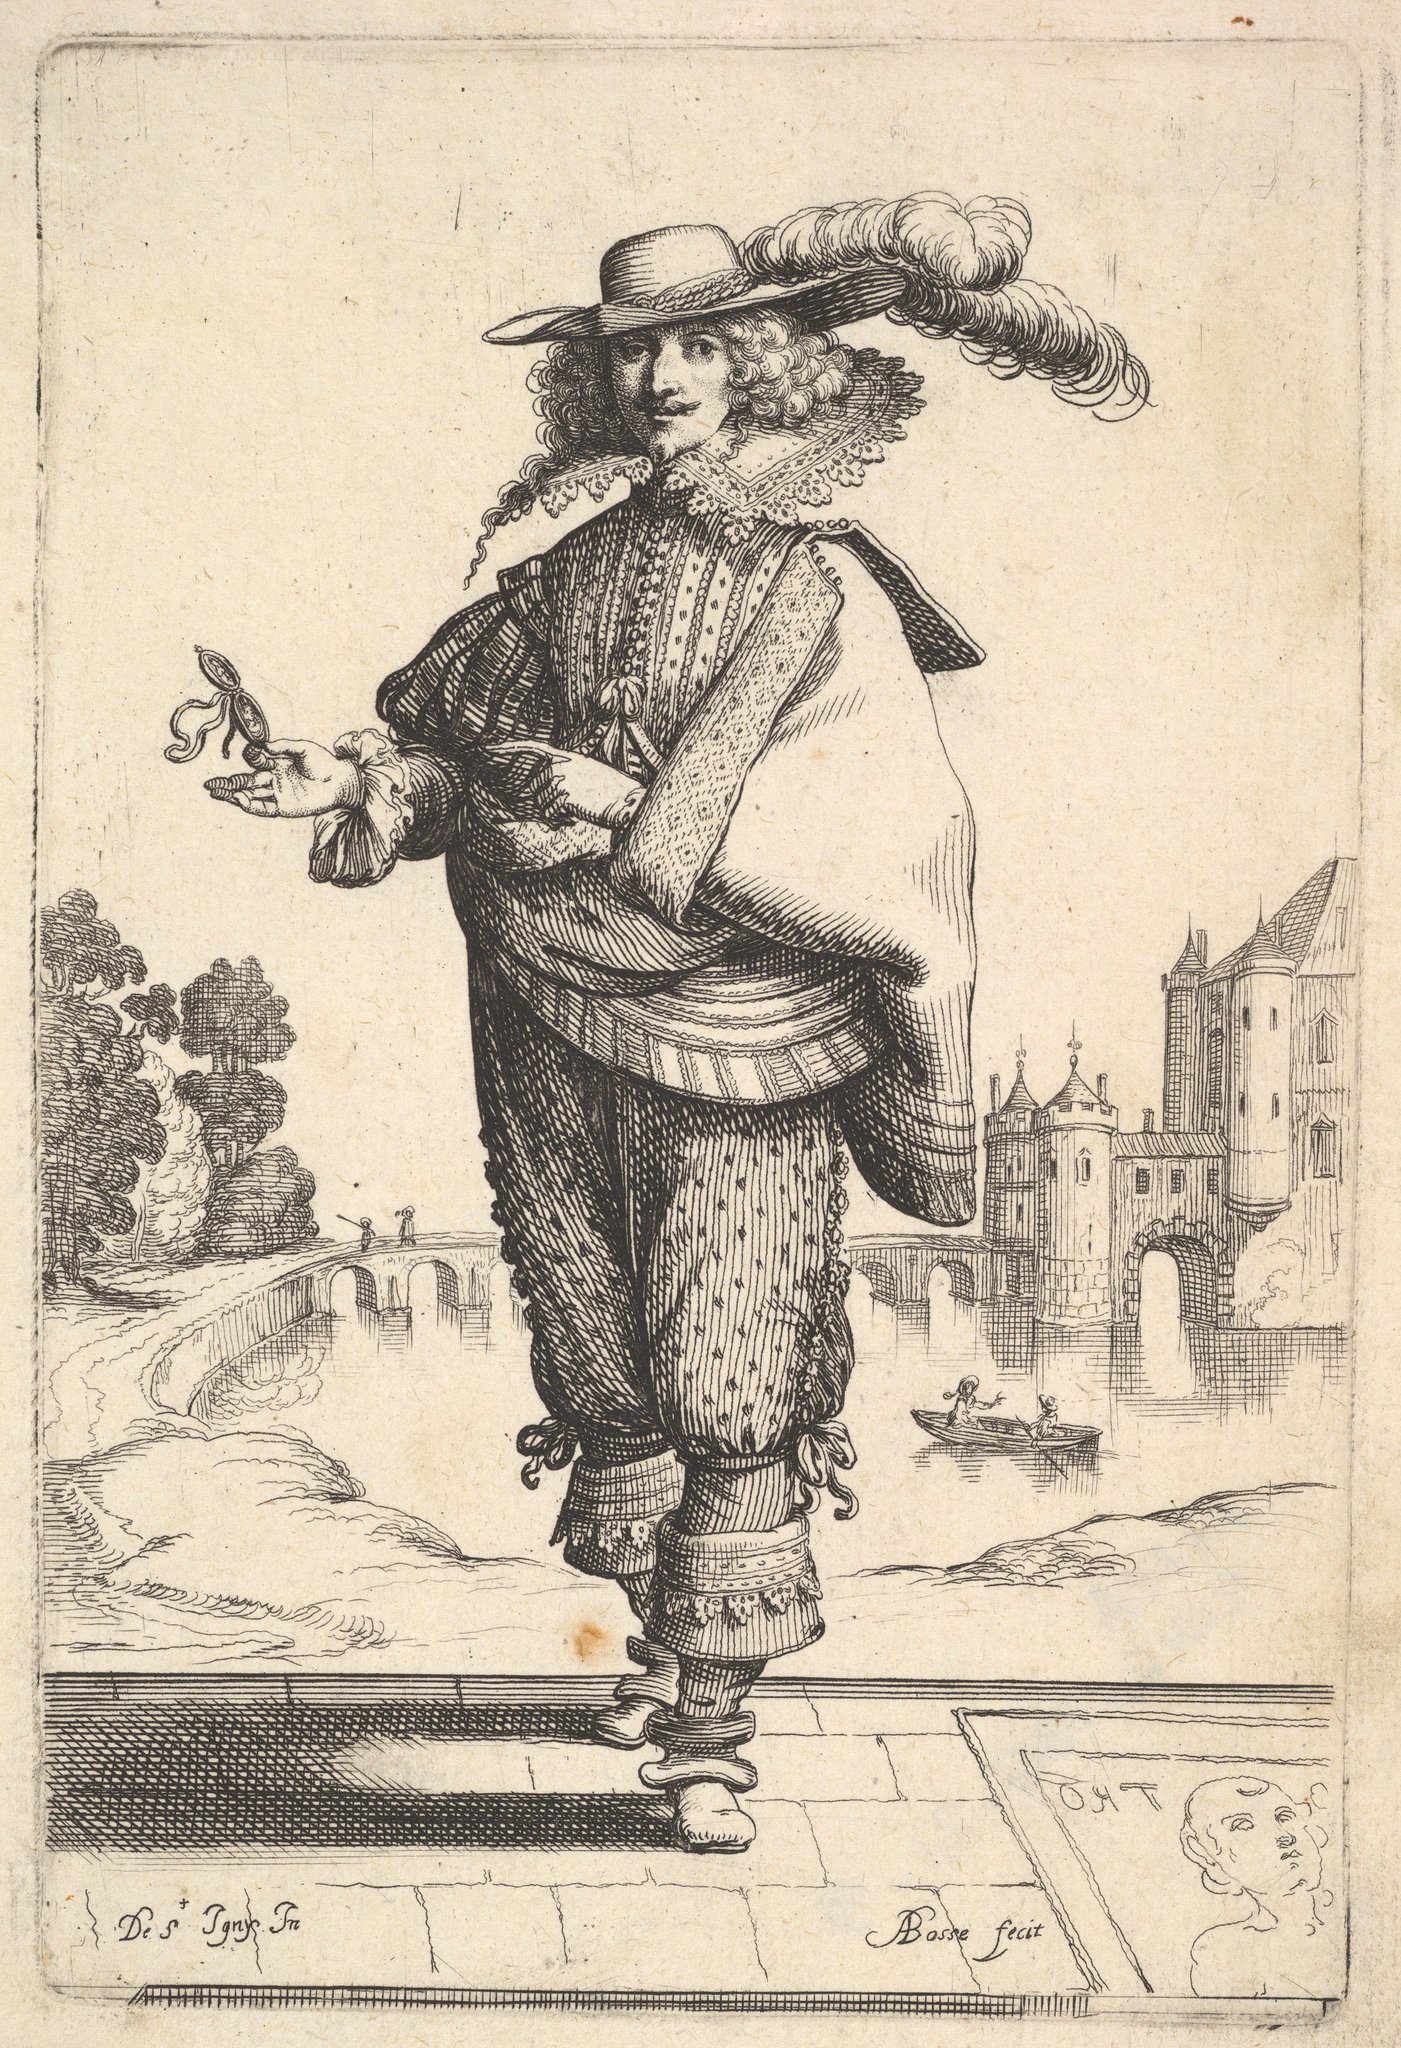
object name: print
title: A gentleman standing in front of a large castle and wearing a plumed hat and a lace collar, the tomb with an engraving of the head of a woman on the ground to right, from "The Garden of the French Nobles In Which One Can Pick Up Their Way of Dressing"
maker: abraham bosse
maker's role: artist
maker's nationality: french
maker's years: 1602-1676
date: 1629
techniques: etching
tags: castles,bridges,men,boats